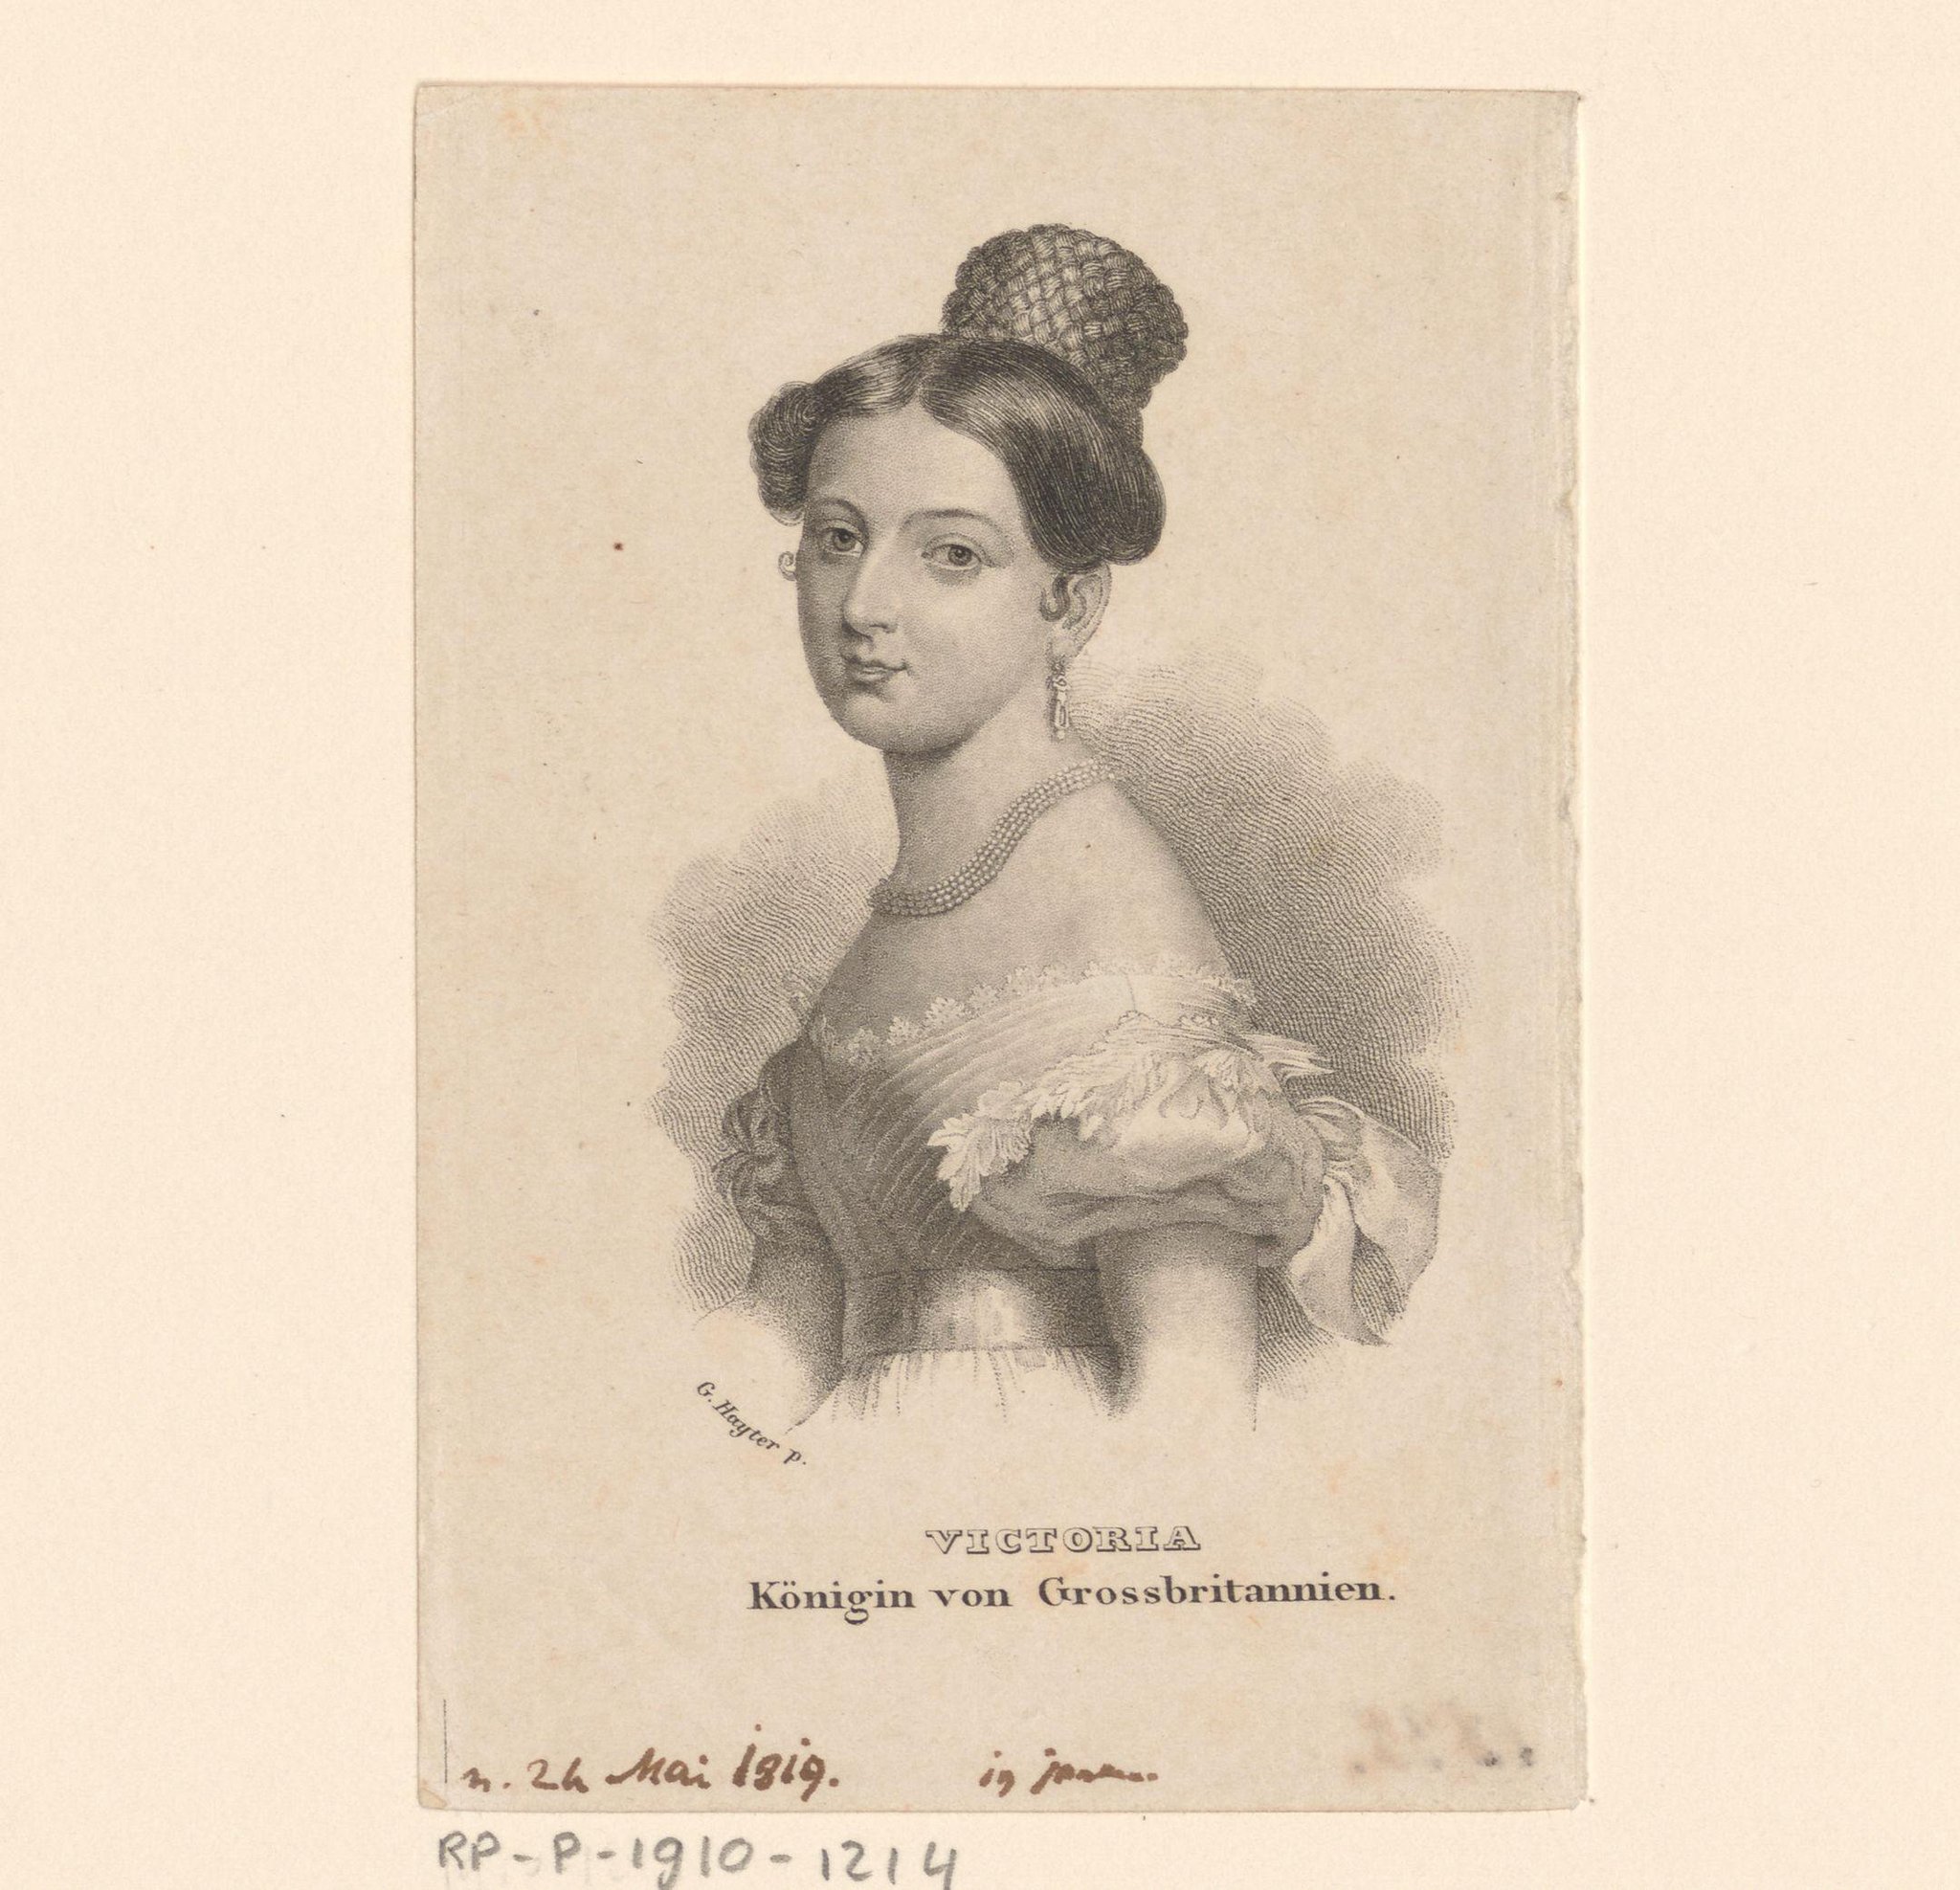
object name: print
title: Portret van Victoria, koningin van het Verenigd Koninkrijk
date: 1837-1870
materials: paper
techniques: stippled etching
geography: germany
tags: victoria (koningin van het verenigd koninkrijk en keizerin van india), historical persons - bb - woman, queen, empress, etc. (wife of a ruler)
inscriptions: inscription: ‘n. 24 Mai 1819 [...]’, collector's mark: Lugt 2228